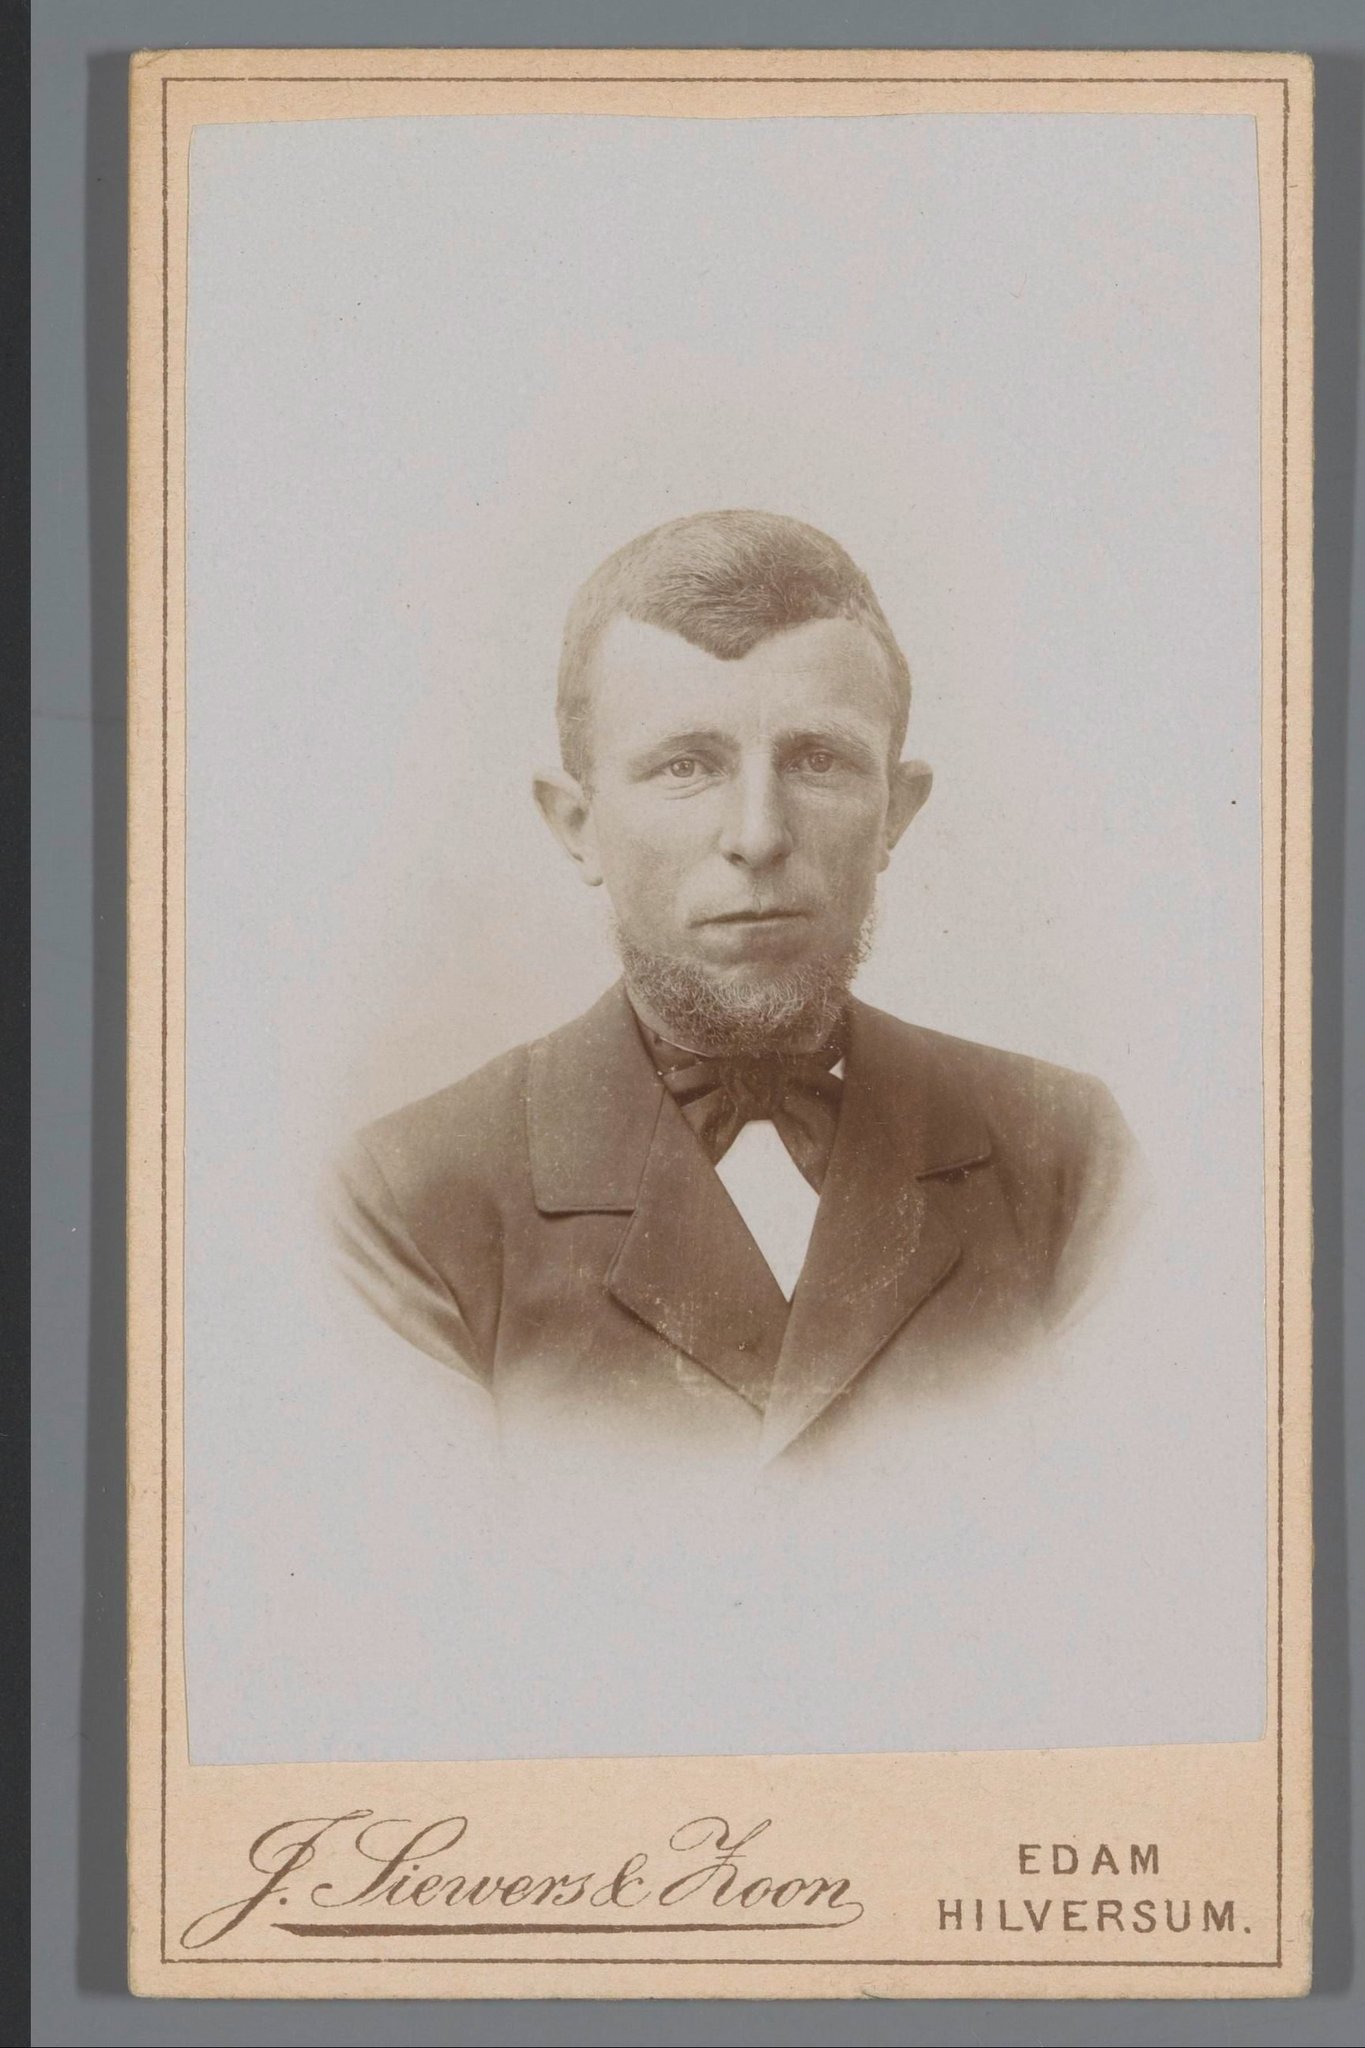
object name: photograph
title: Portret van Cornelis Ton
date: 1890-1918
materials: cardboard, celluloid, paper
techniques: albumen print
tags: adult man, historical persons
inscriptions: inscription: ‘Photographische/ ATELIERS/ J. Siewers & Zoon/ EDAM/ HILVERSUM.’, inscription: ‘Cornelis Ton van L. L.’